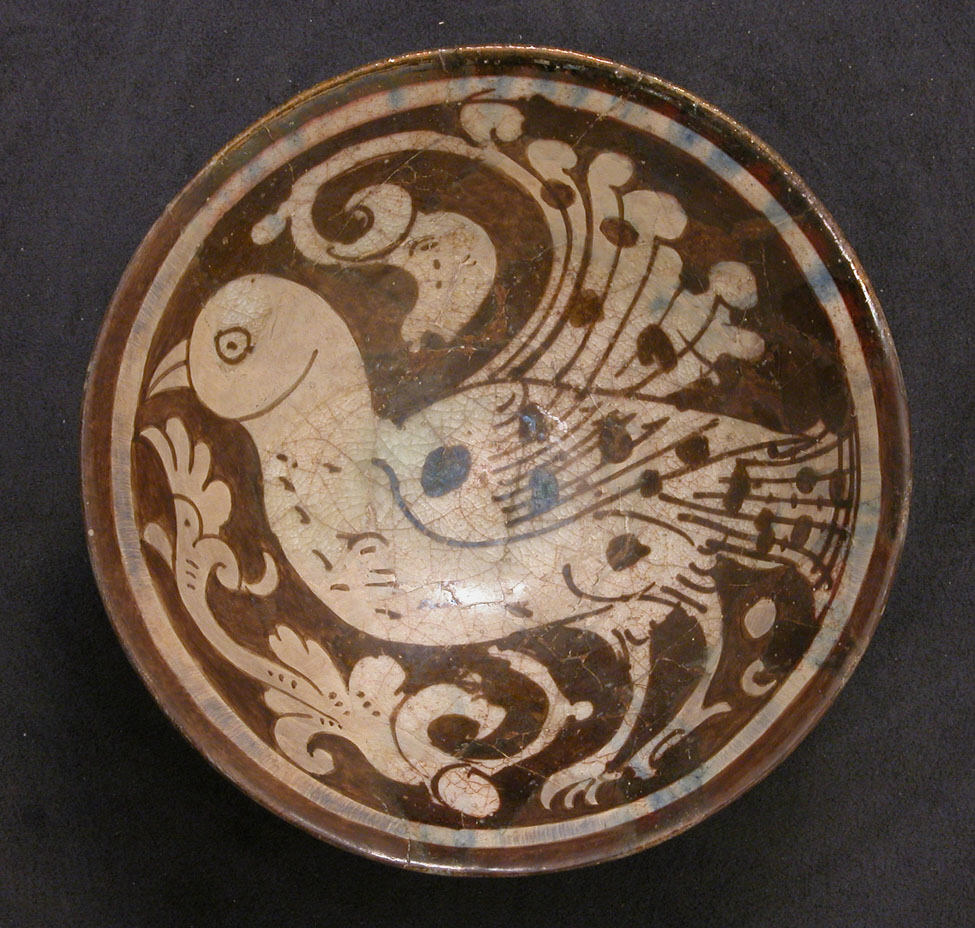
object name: bowl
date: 1101-1300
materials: glaze, stonepaste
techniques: luster painting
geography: iran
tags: birds